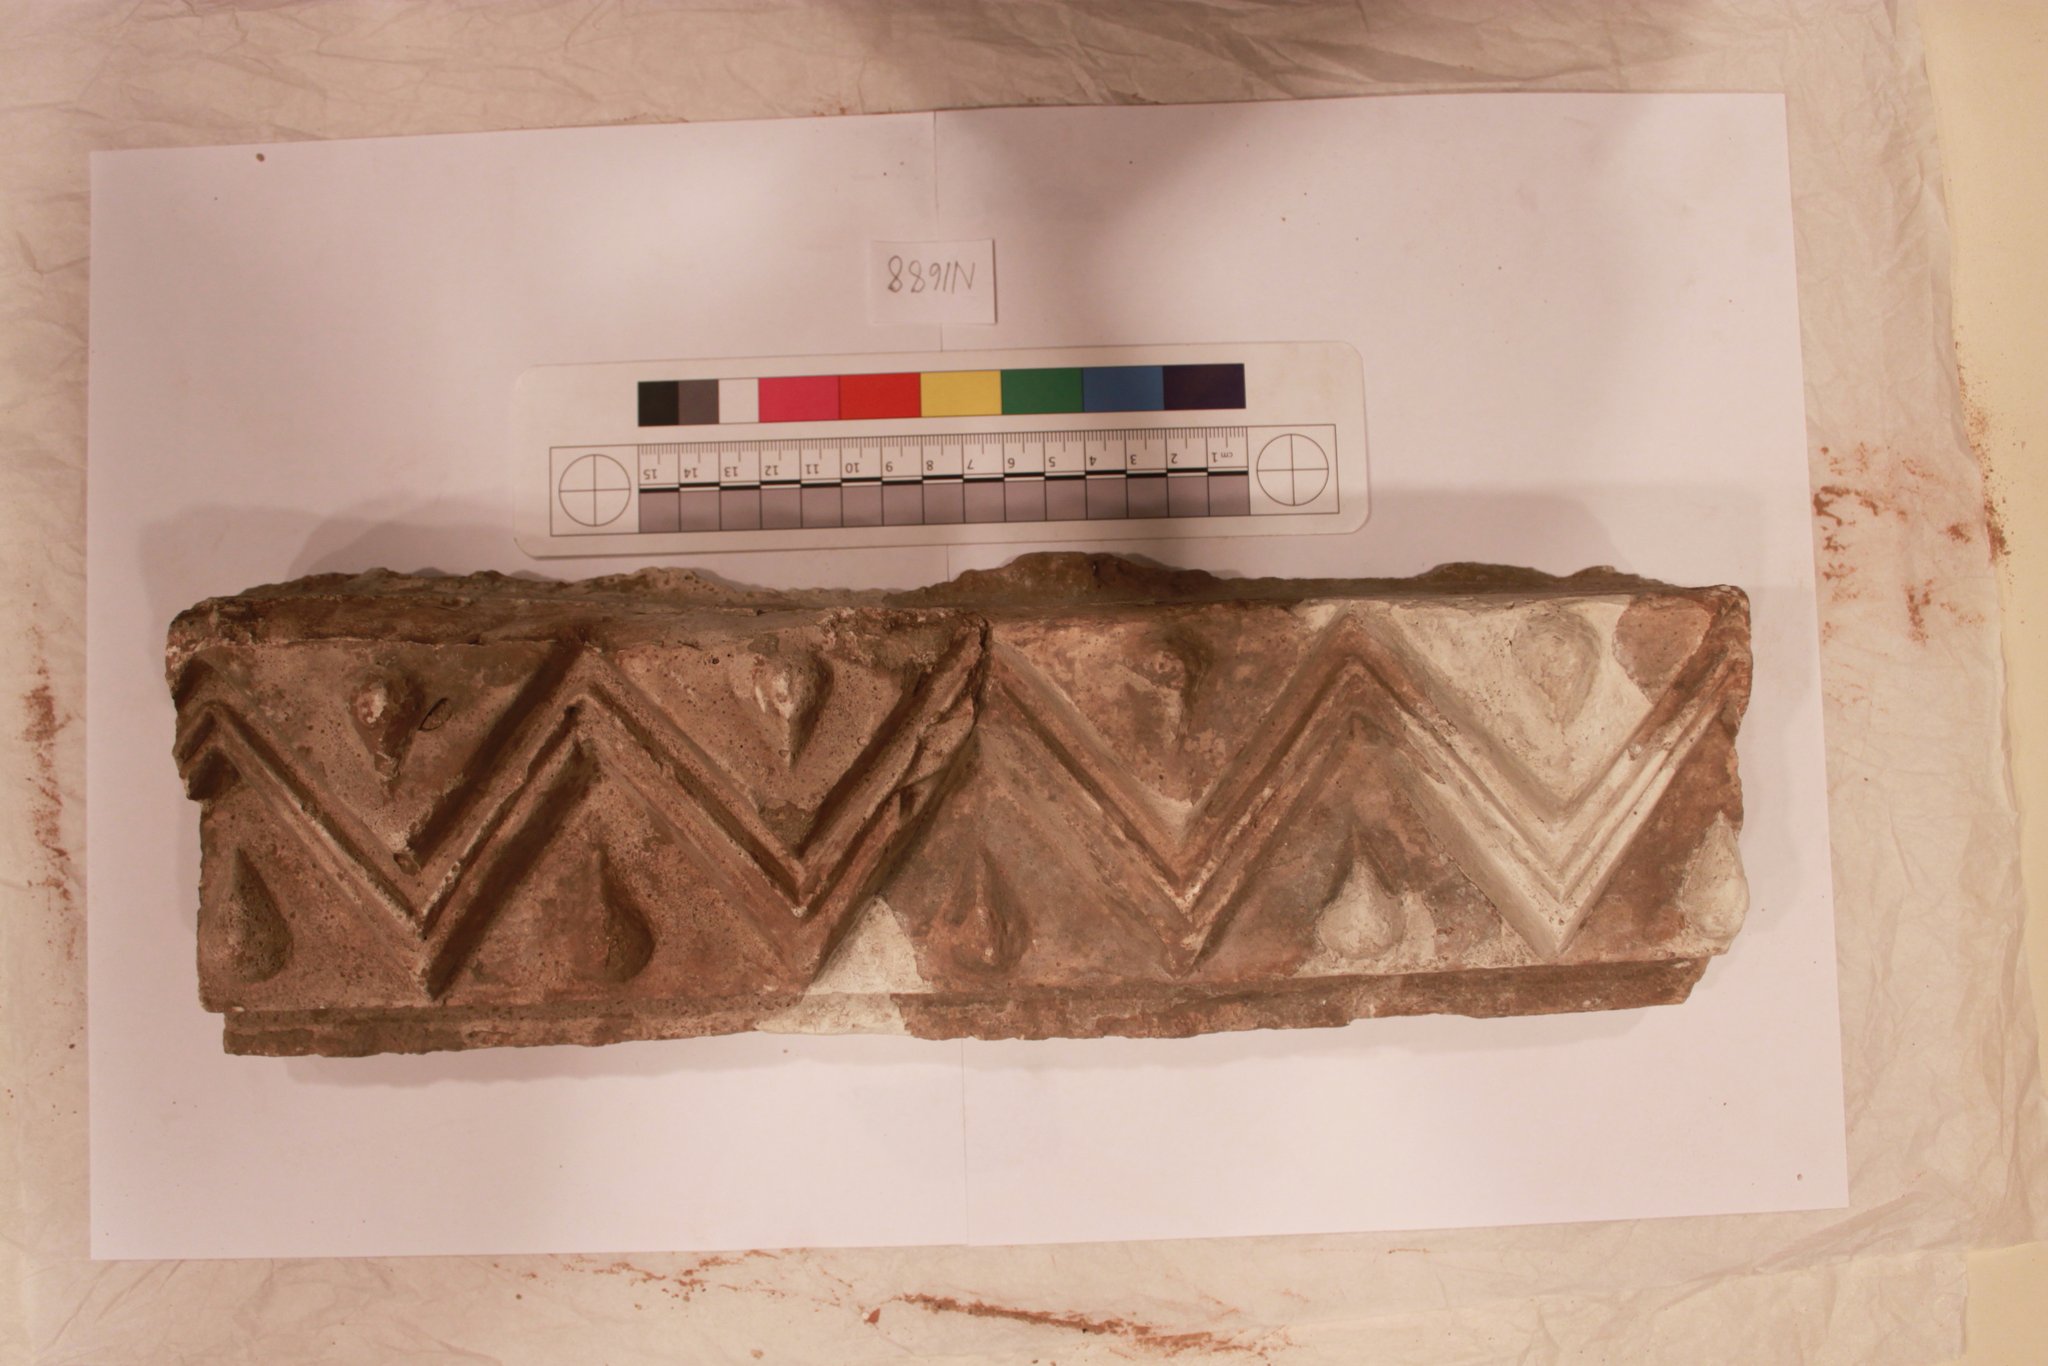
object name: fragment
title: Stucco Fragment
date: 701-1200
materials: plaster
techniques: carving, painting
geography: iran